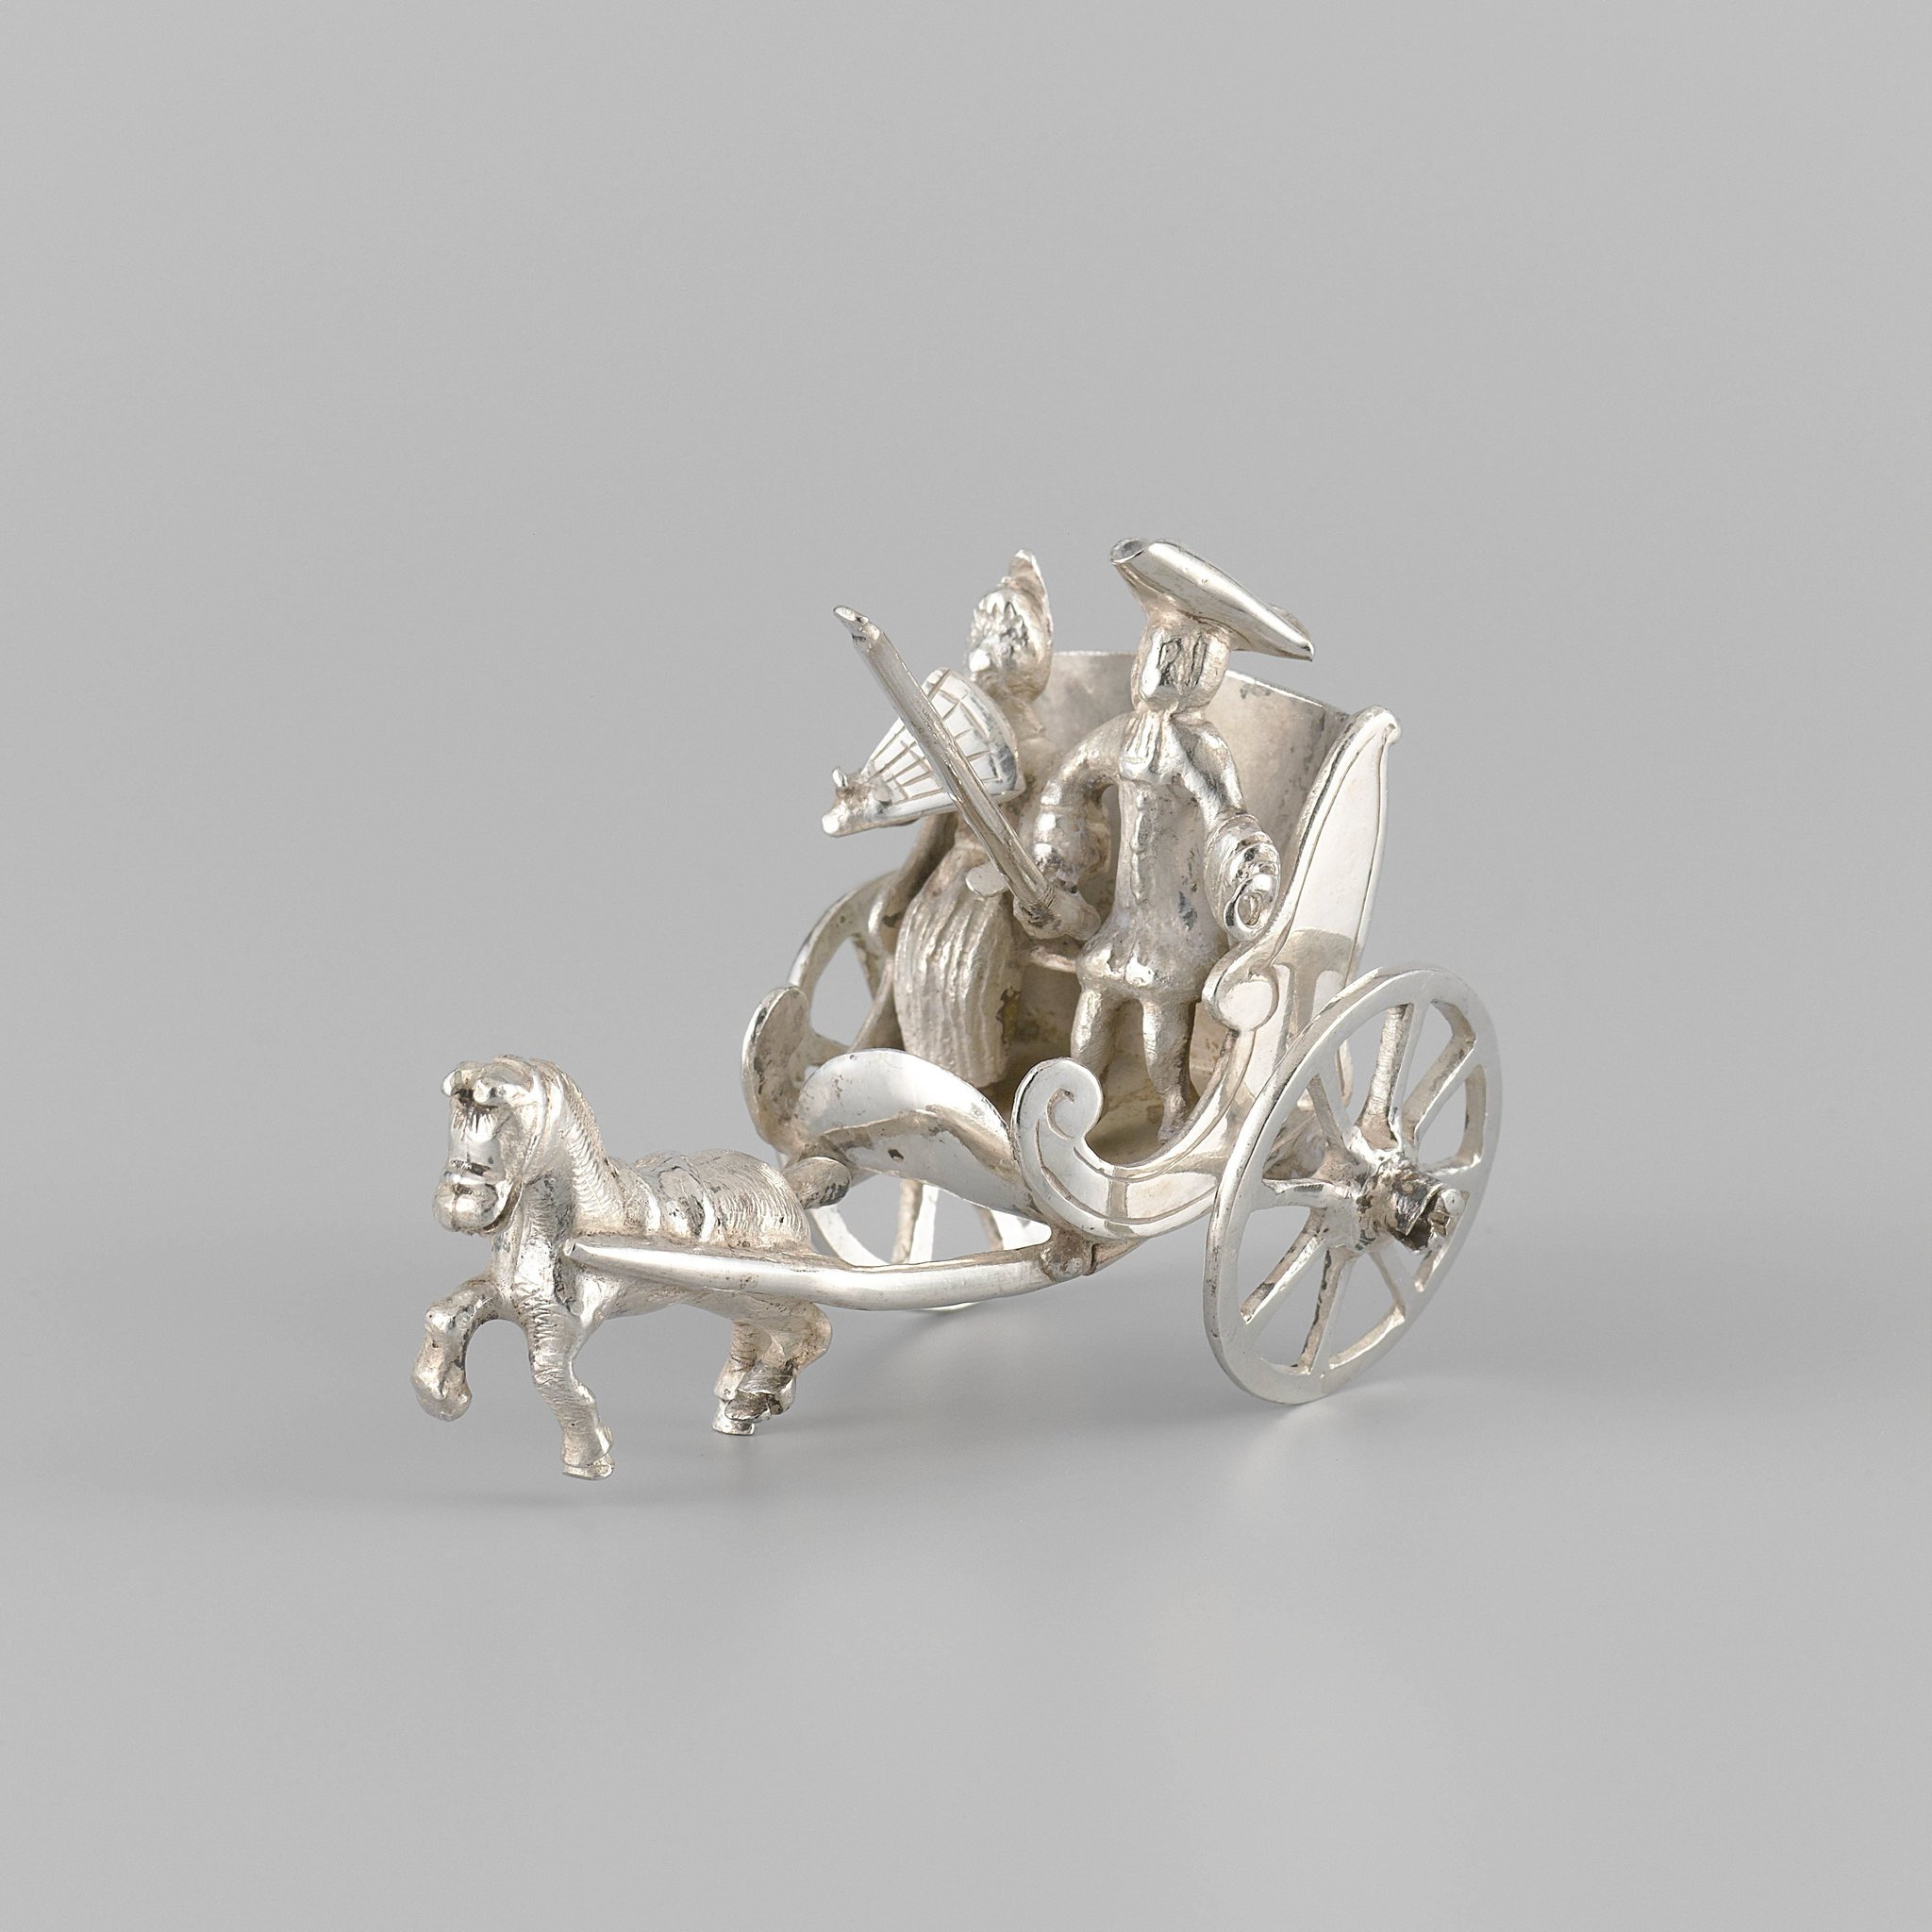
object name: miniature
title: Sjees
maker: abraham van der hoeff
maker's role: silversmith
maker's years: 1686-1735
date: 1704-1734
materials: silver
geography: haarlem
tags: fan, two-wheeled vehicle drawn by two animals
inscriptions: maker's mark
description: Sjees zonder kap, getrokken door een paard. In de sjees zit een man met een steek en in zijn rechterhand een stok en een vrouw met in haar rechterhand een waaier. Het beeld is gemerkt: stk.= Haarlem, mt.= toegeschreven aan Abraham van der Hoeff, en een dolfijn.